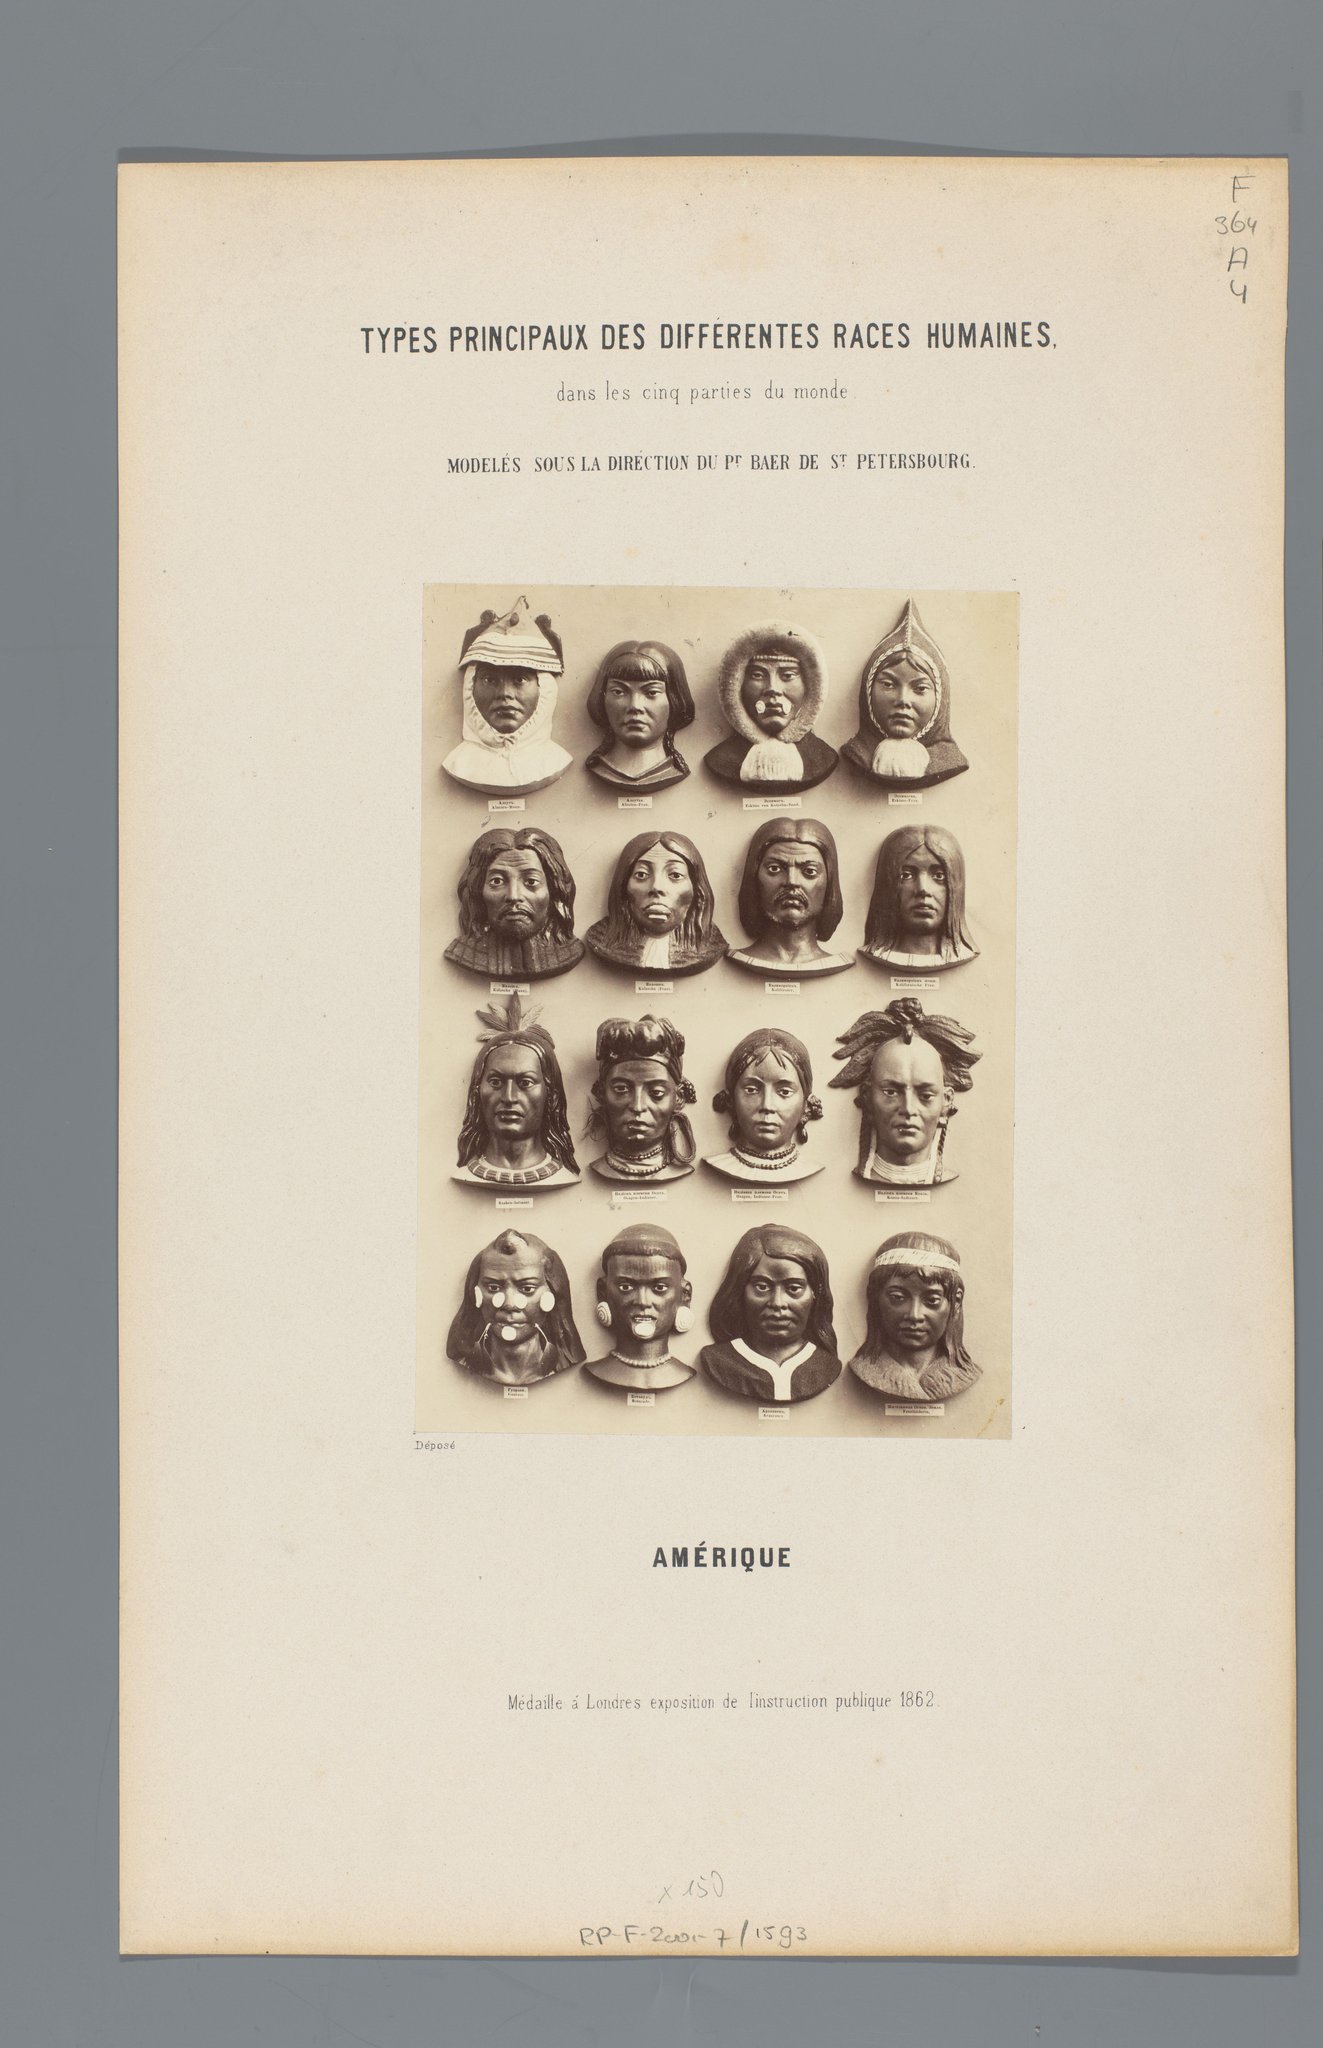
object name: photograph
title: Amérique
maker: Anonymous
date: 1857-1862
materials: paper, photographic support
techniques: albumen print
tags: indigenous peoples of north america, piece of sculpture, reproduction of a piece of sculpture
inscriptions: number: ‘x150’, inscription: ‘Déposé’, inscription: ‘Médaille á Londres exposition de l'instruction publique 1862.’, inscription: ‘TYPES PRINCIPAUX DES DIFFÉRENTES RACES HUMAINES./ dans les cinq parties du monde/ MODELÉS SOUS LA DIRÉCTION DU Pr BAER DE St PETERSBOURG.’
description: Deze foto maakt deel uit van een omslag met vijf foto's.